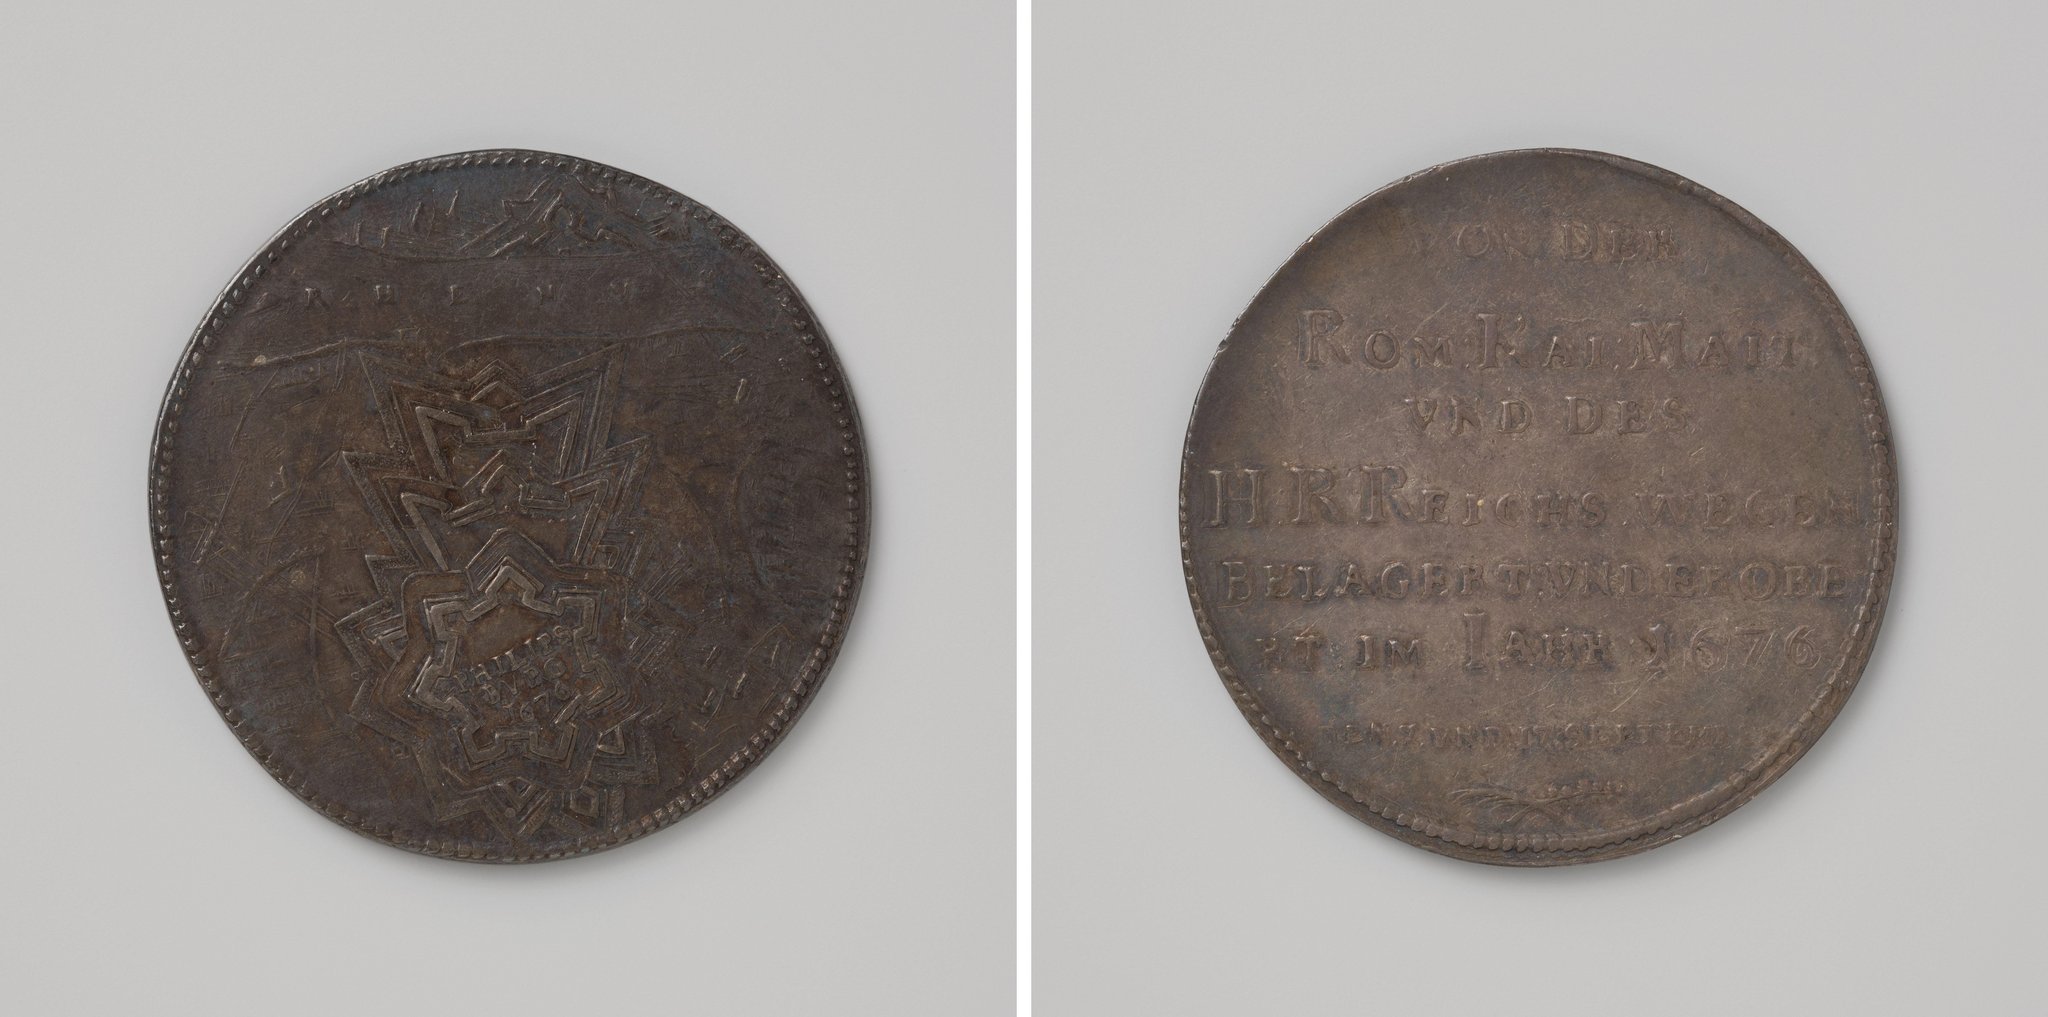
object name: history medal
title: Verovering van Philippsburg door keizer Leopold I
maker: Anonymous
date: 1676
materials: silver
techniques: striking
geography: germany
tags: leopold i (keizer van duitsland)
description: Zilveren penning. Voorzijde: plattegrond van stad. Keerzijde: opschrift.